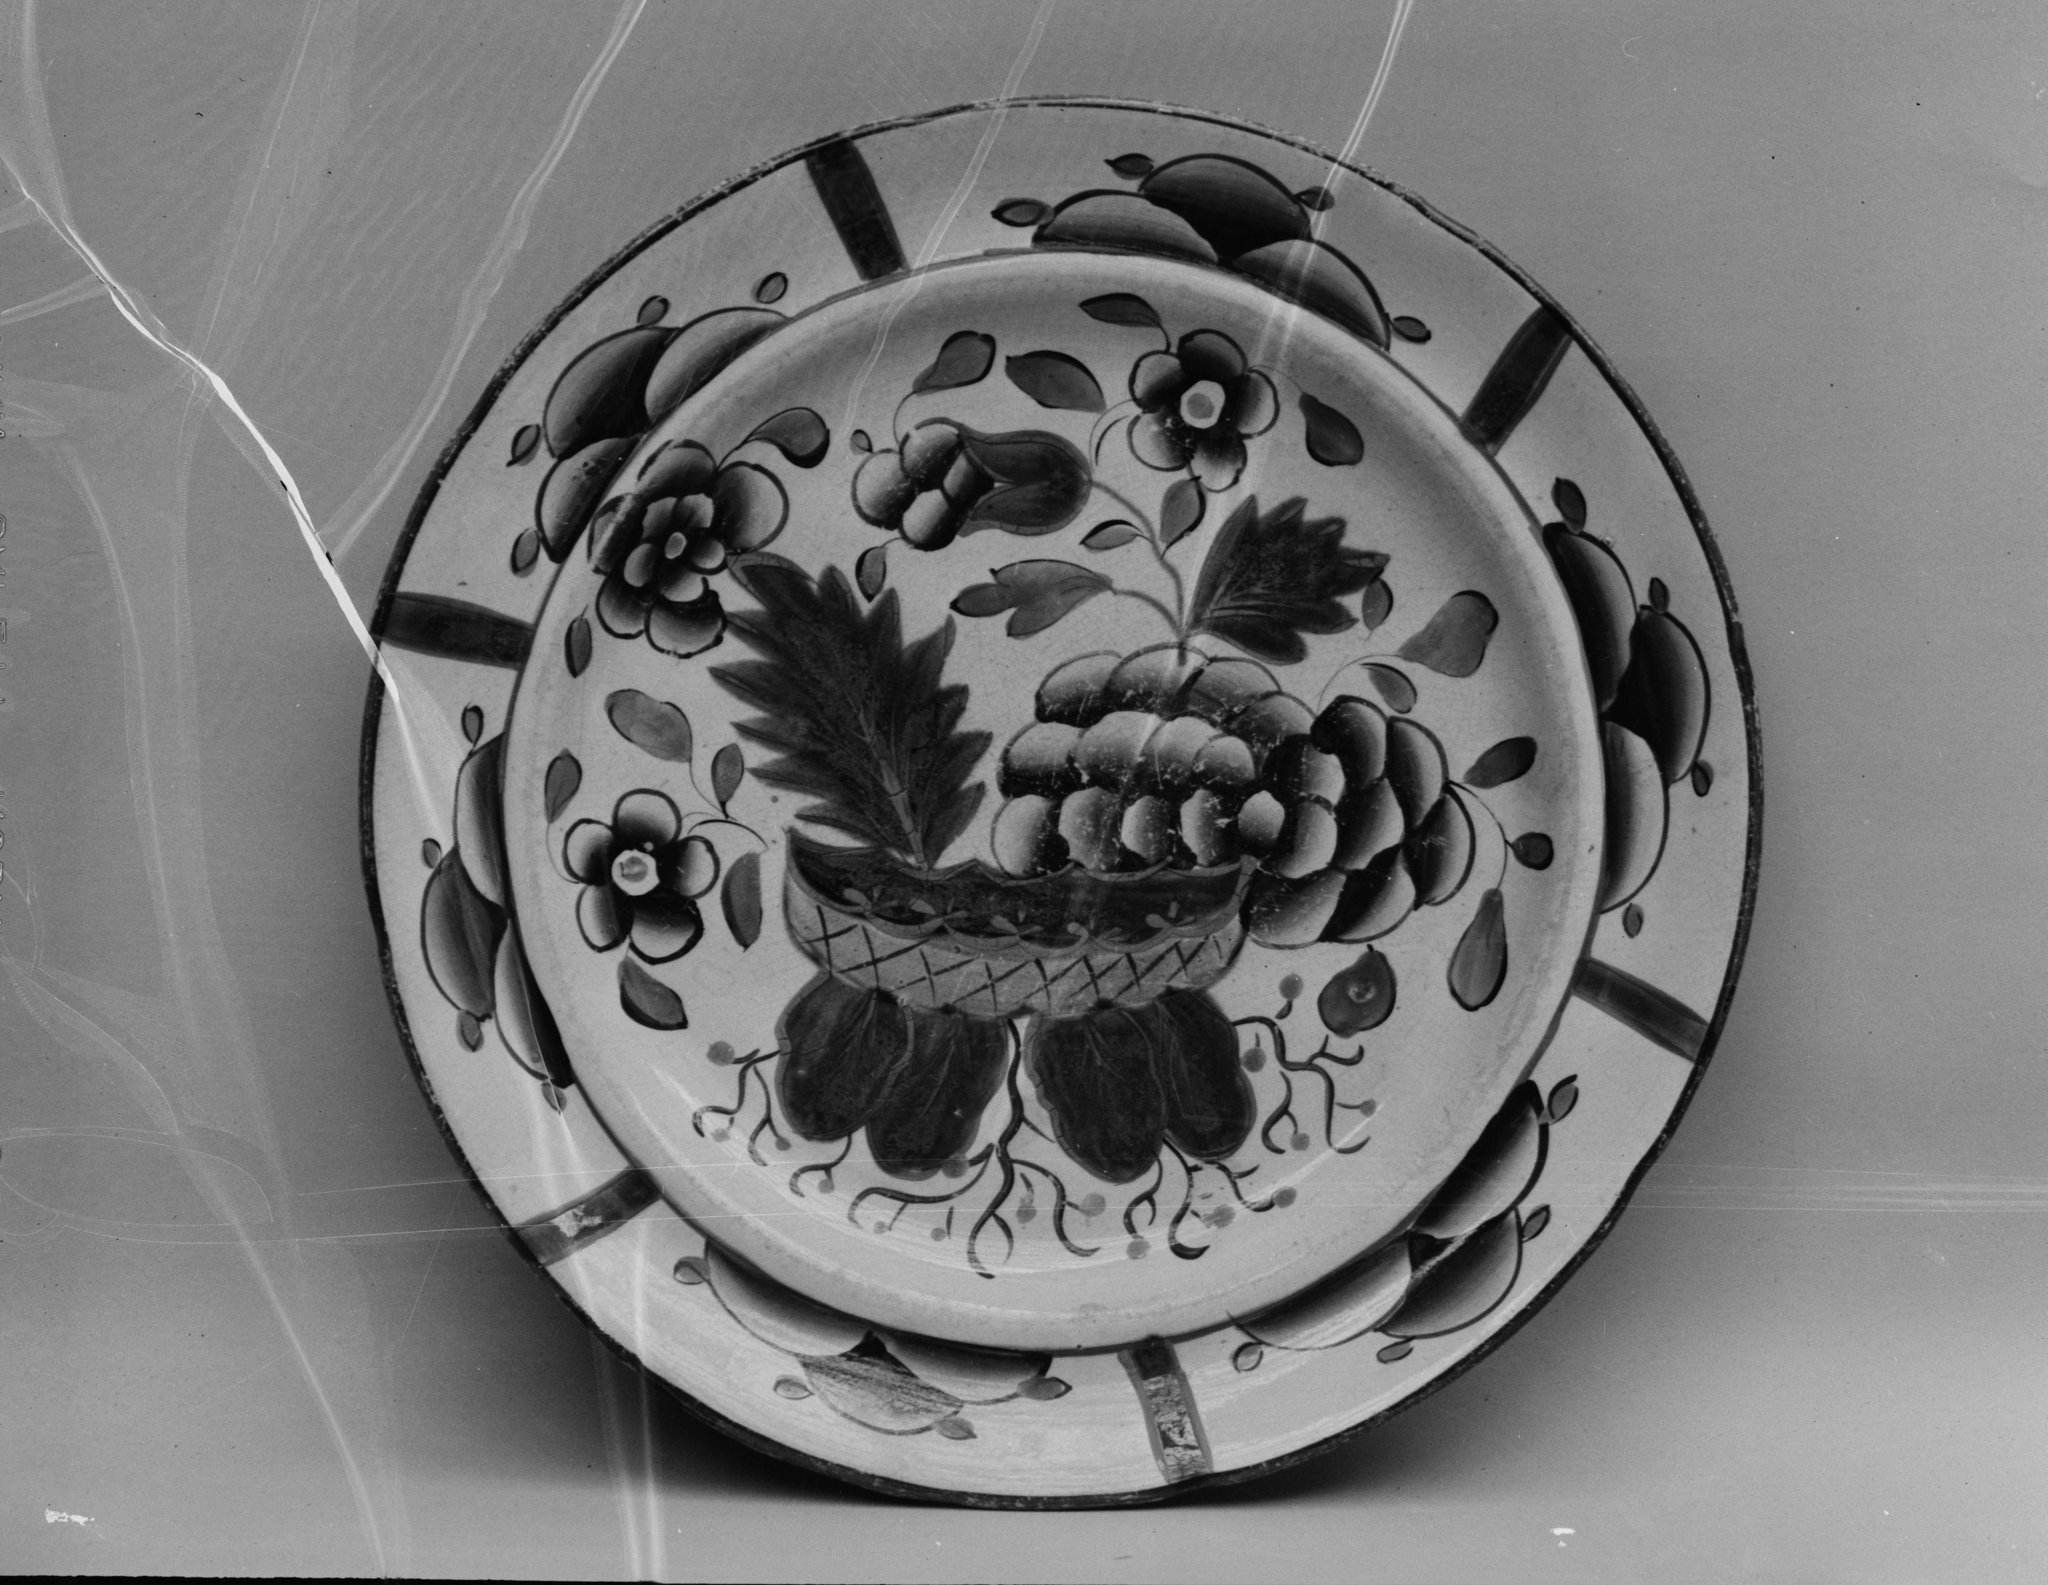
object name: plate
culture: british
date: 1825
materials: earthenware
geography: england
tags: fruit,flowers